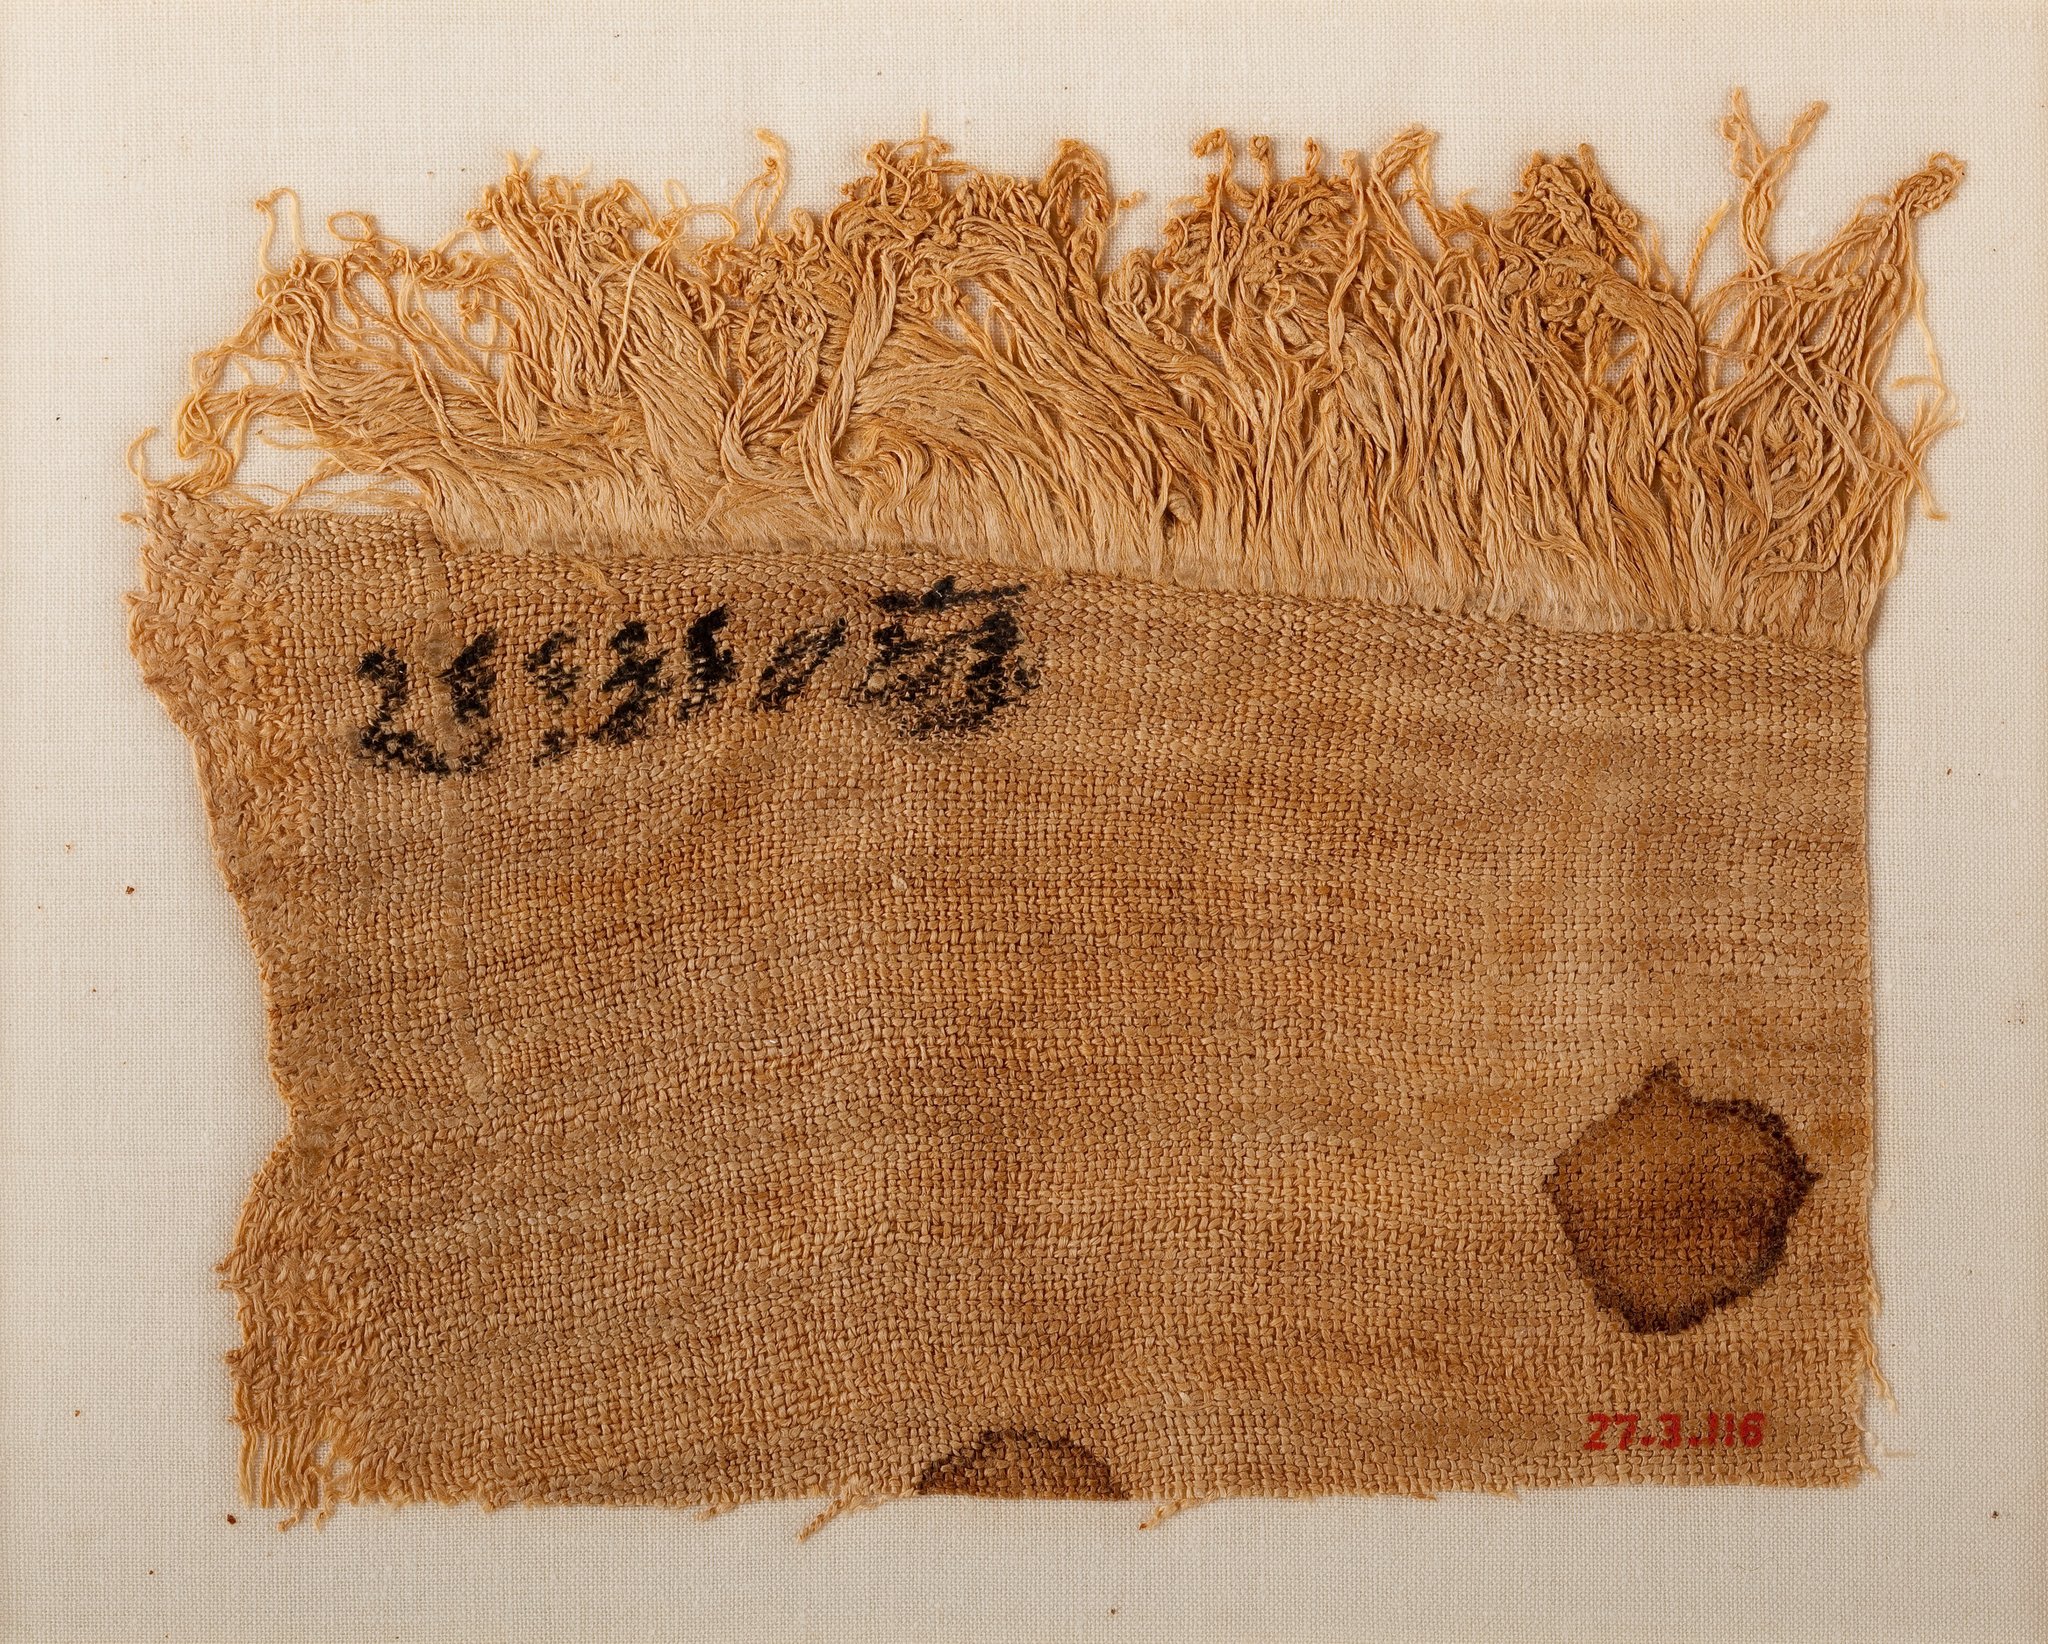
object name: linen mark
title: Linen mark (Type XIX)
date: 1961-1917 BCE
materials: linen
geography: egypt